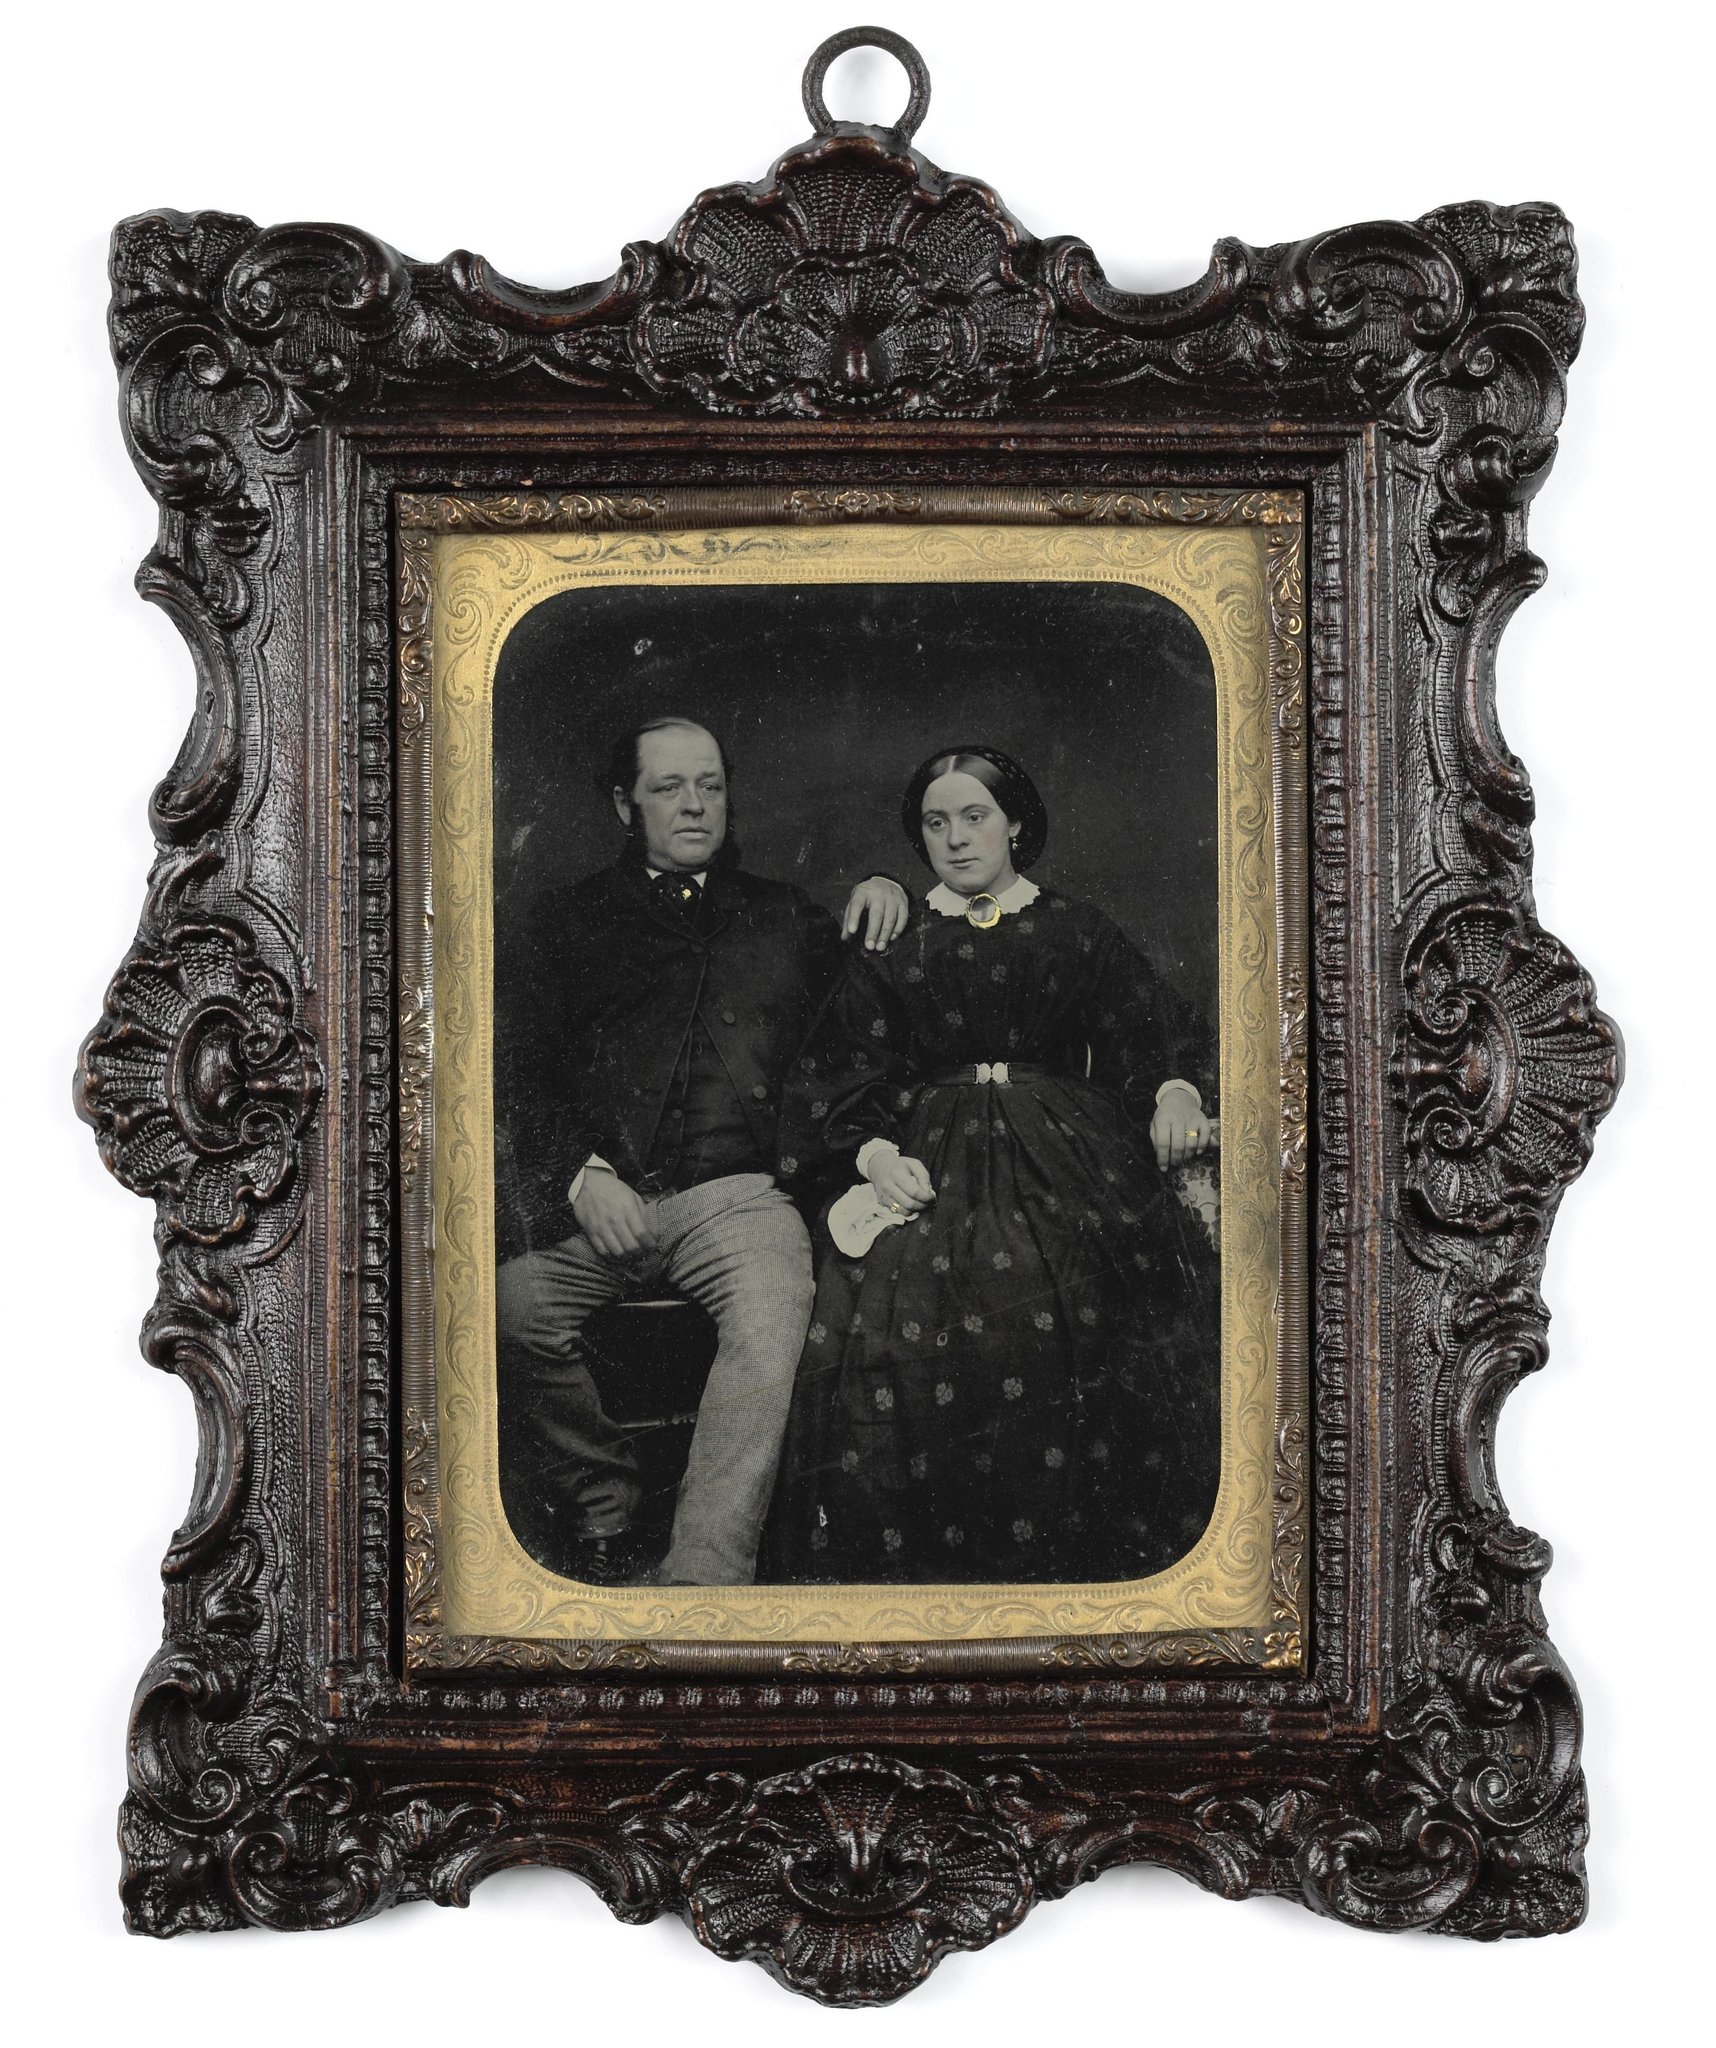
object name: photograph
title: Portret van een onbekend echtpaar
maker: Anonymous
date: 1855-1870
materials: cardboard, glass, metal, wood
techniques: ambrotype, hand coloring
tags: historical persons - bb - woman, historical persons, marriage, married couple, 'matrimonium'